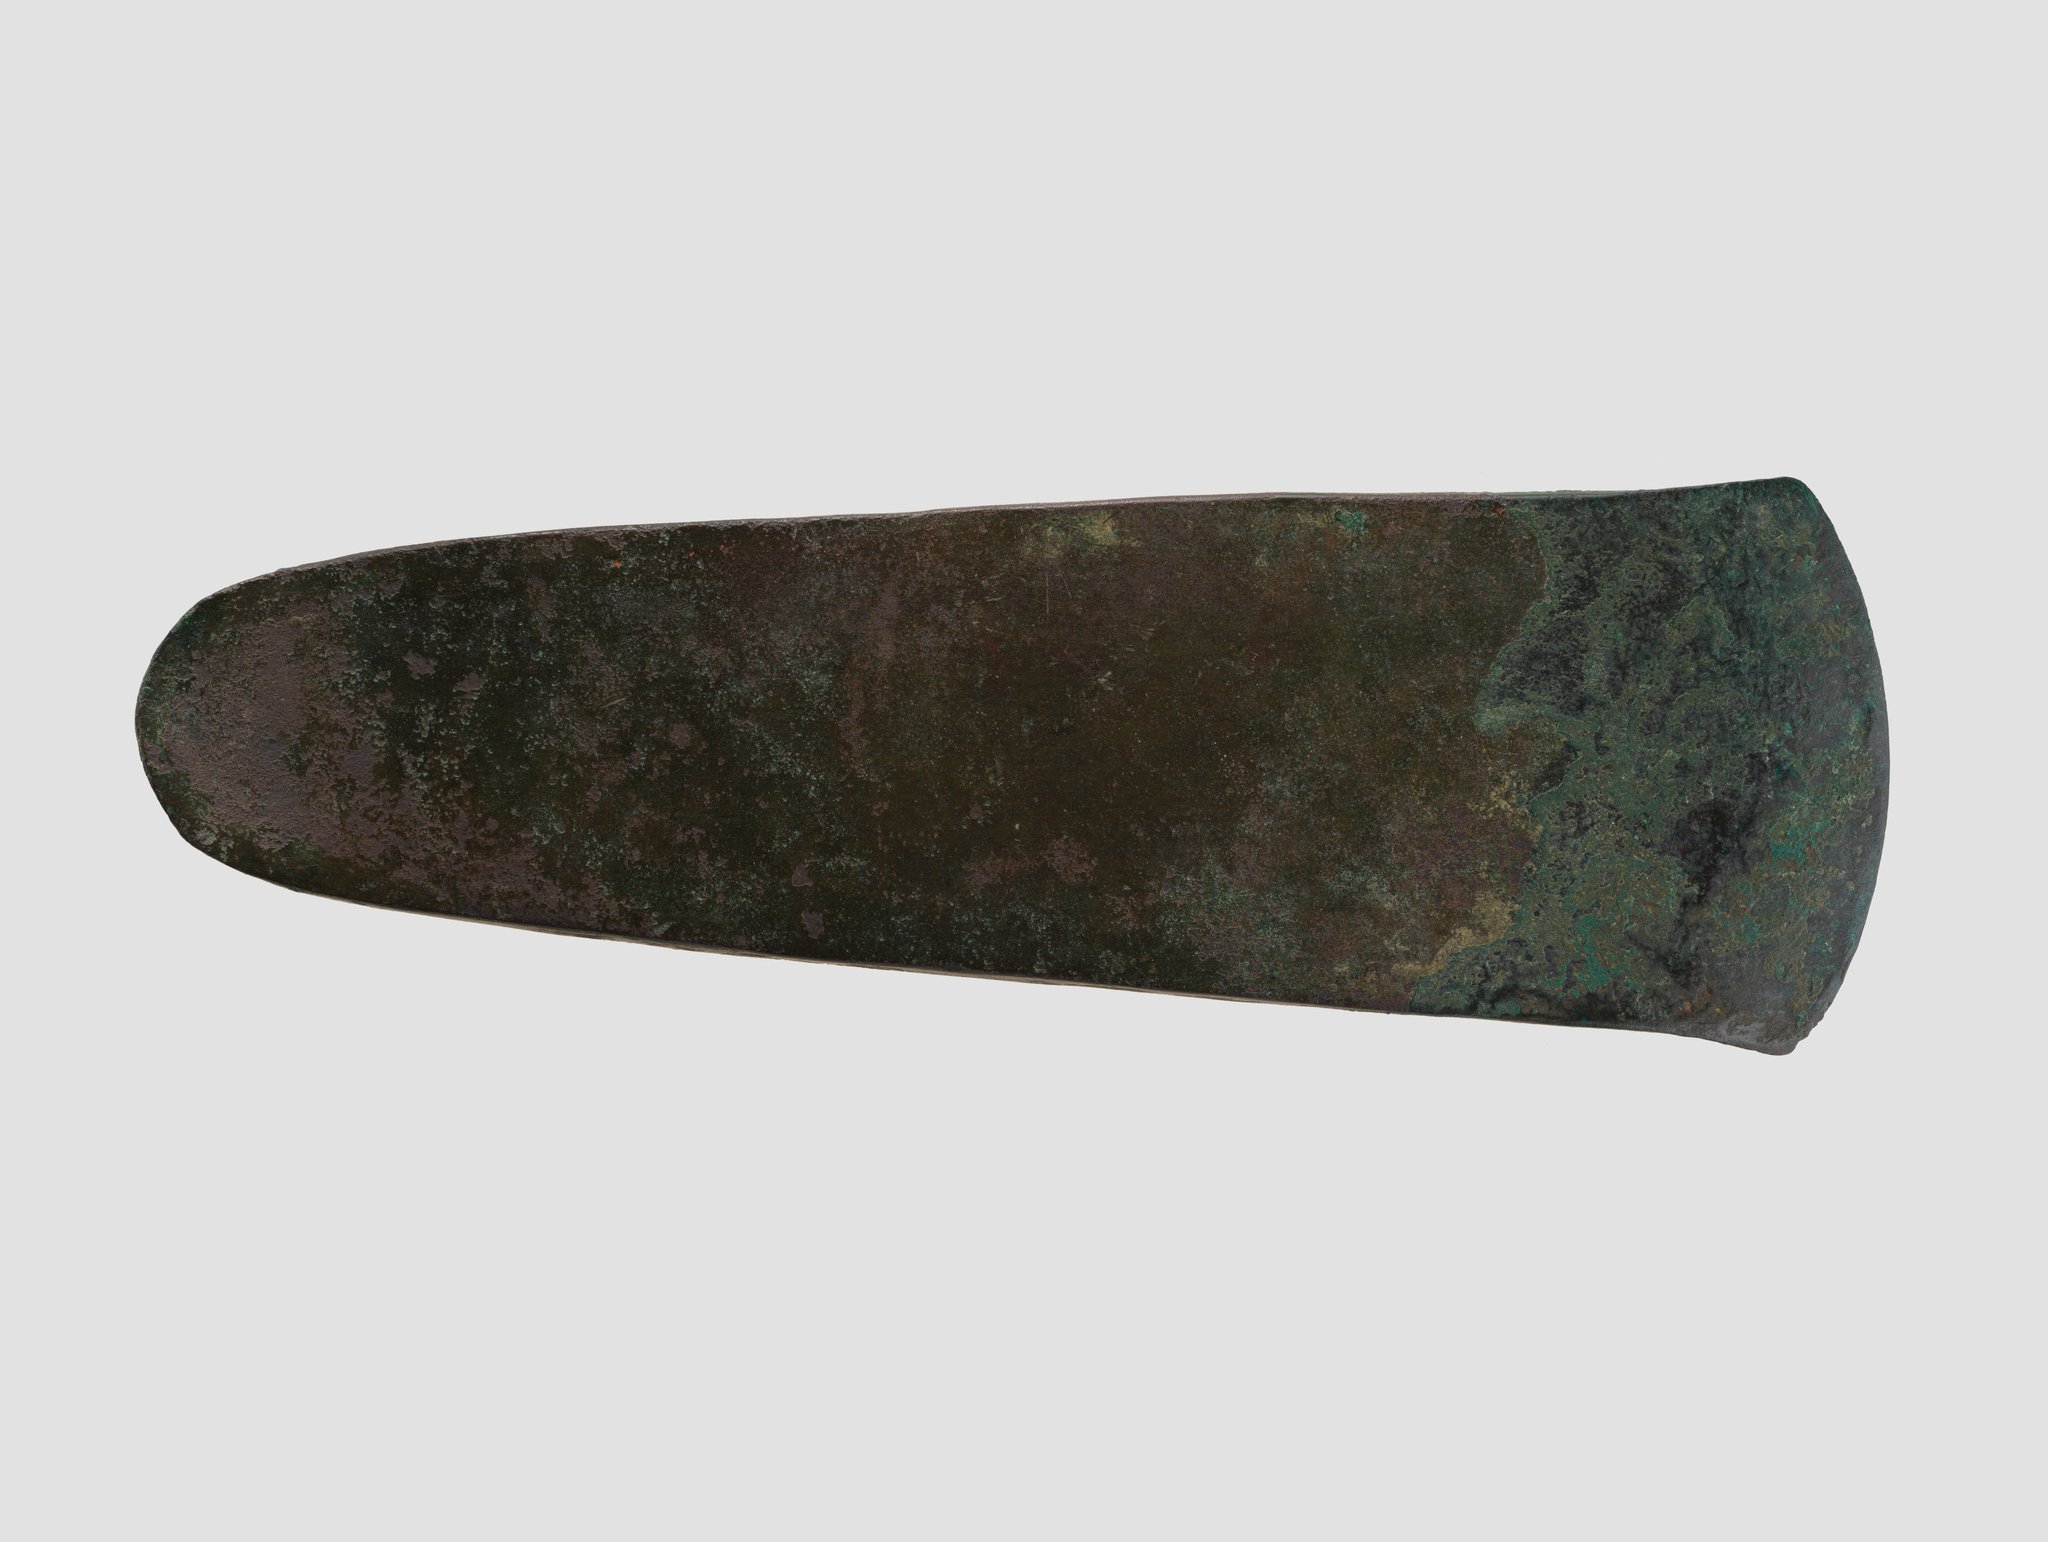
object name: axe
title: Axe head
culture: hattian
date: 2300-2000 BCE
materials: bronze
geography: central anatolia